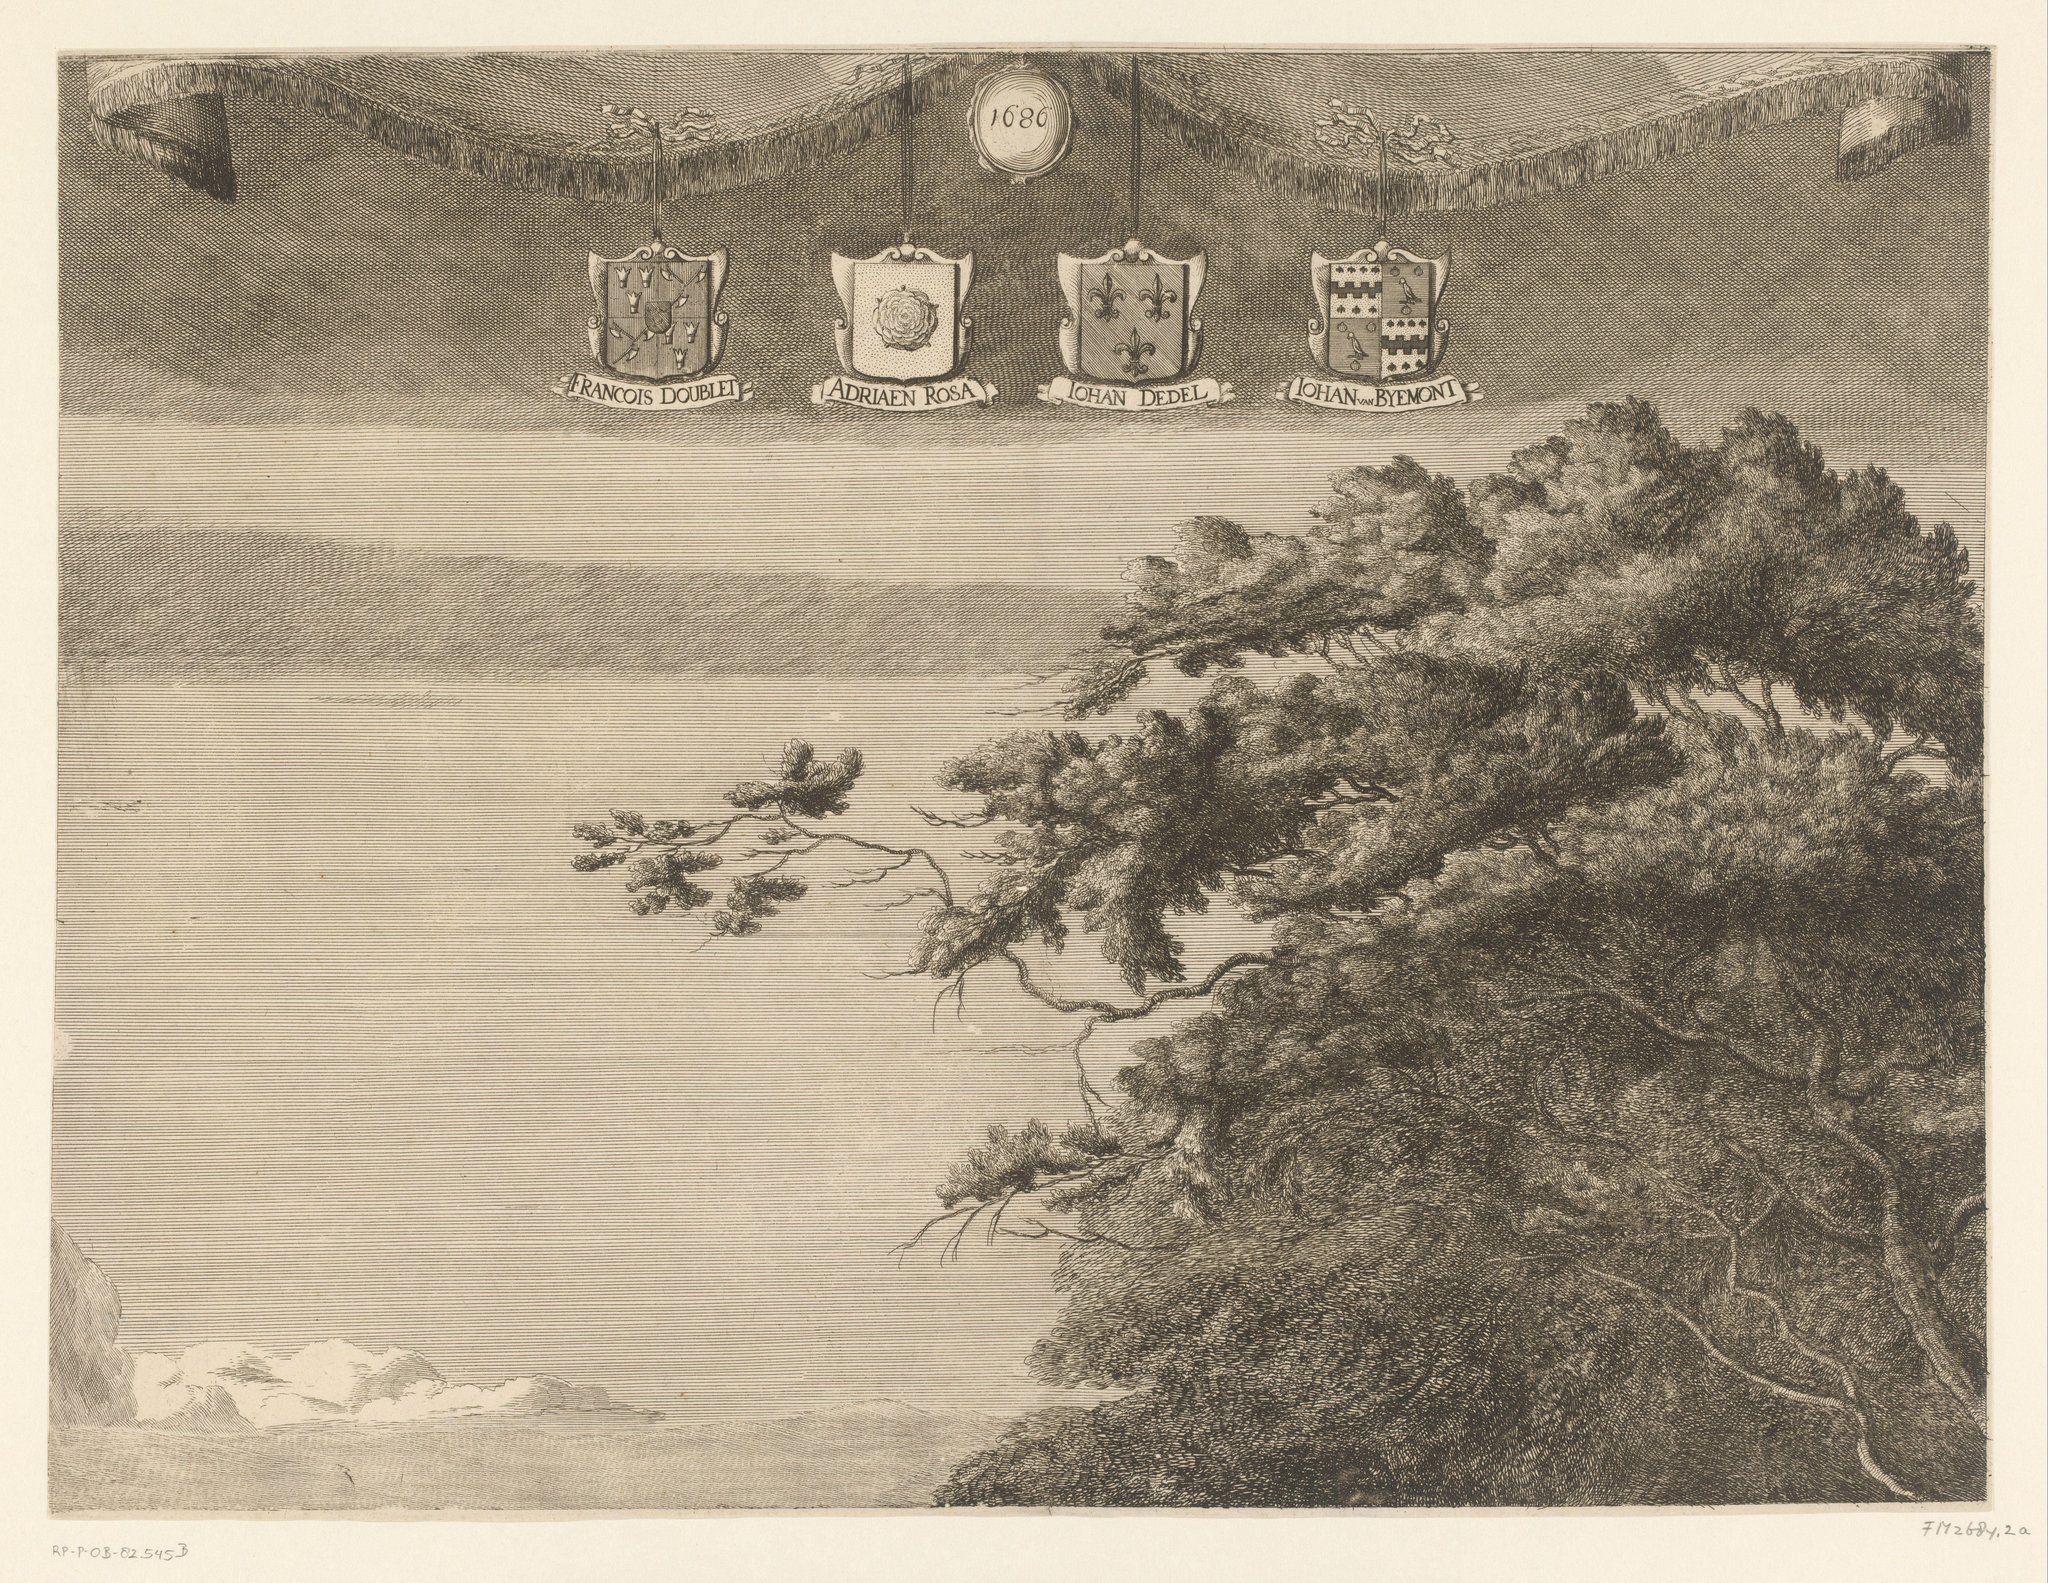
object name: print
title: Wandelrit van prins Willem III buiten Den Haag (blad middenboven), 1686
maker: johannes kip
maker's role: print maker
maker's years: 1652-1722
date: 1686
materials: paper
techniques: engraving, etching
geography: northern netherlands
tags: william iii (prince of orange and king of england, scotland, and ireland), london, maria ii stuart (koningin van engeland, schotland en ierland), outing, pleasure trip, the hague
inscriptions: date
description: Wandelrit van prins Willem III buiten Den Haag, 1686. Het blad middenboven: wolken, bomen en de wapens van de vier Haagse burgemeesters: François Doublet, Adriaen Rosa, Johan dedel en Johan van Byemont. Onderdeel van een ongemonteerd geheel van 6 bladen (zonder tekstbladen) met een voorstelling van de prins en prinses die een plezierrit in een koets maken, begeleid door een escorte van ruiters. Op de achtergrond de stad Den Haag.